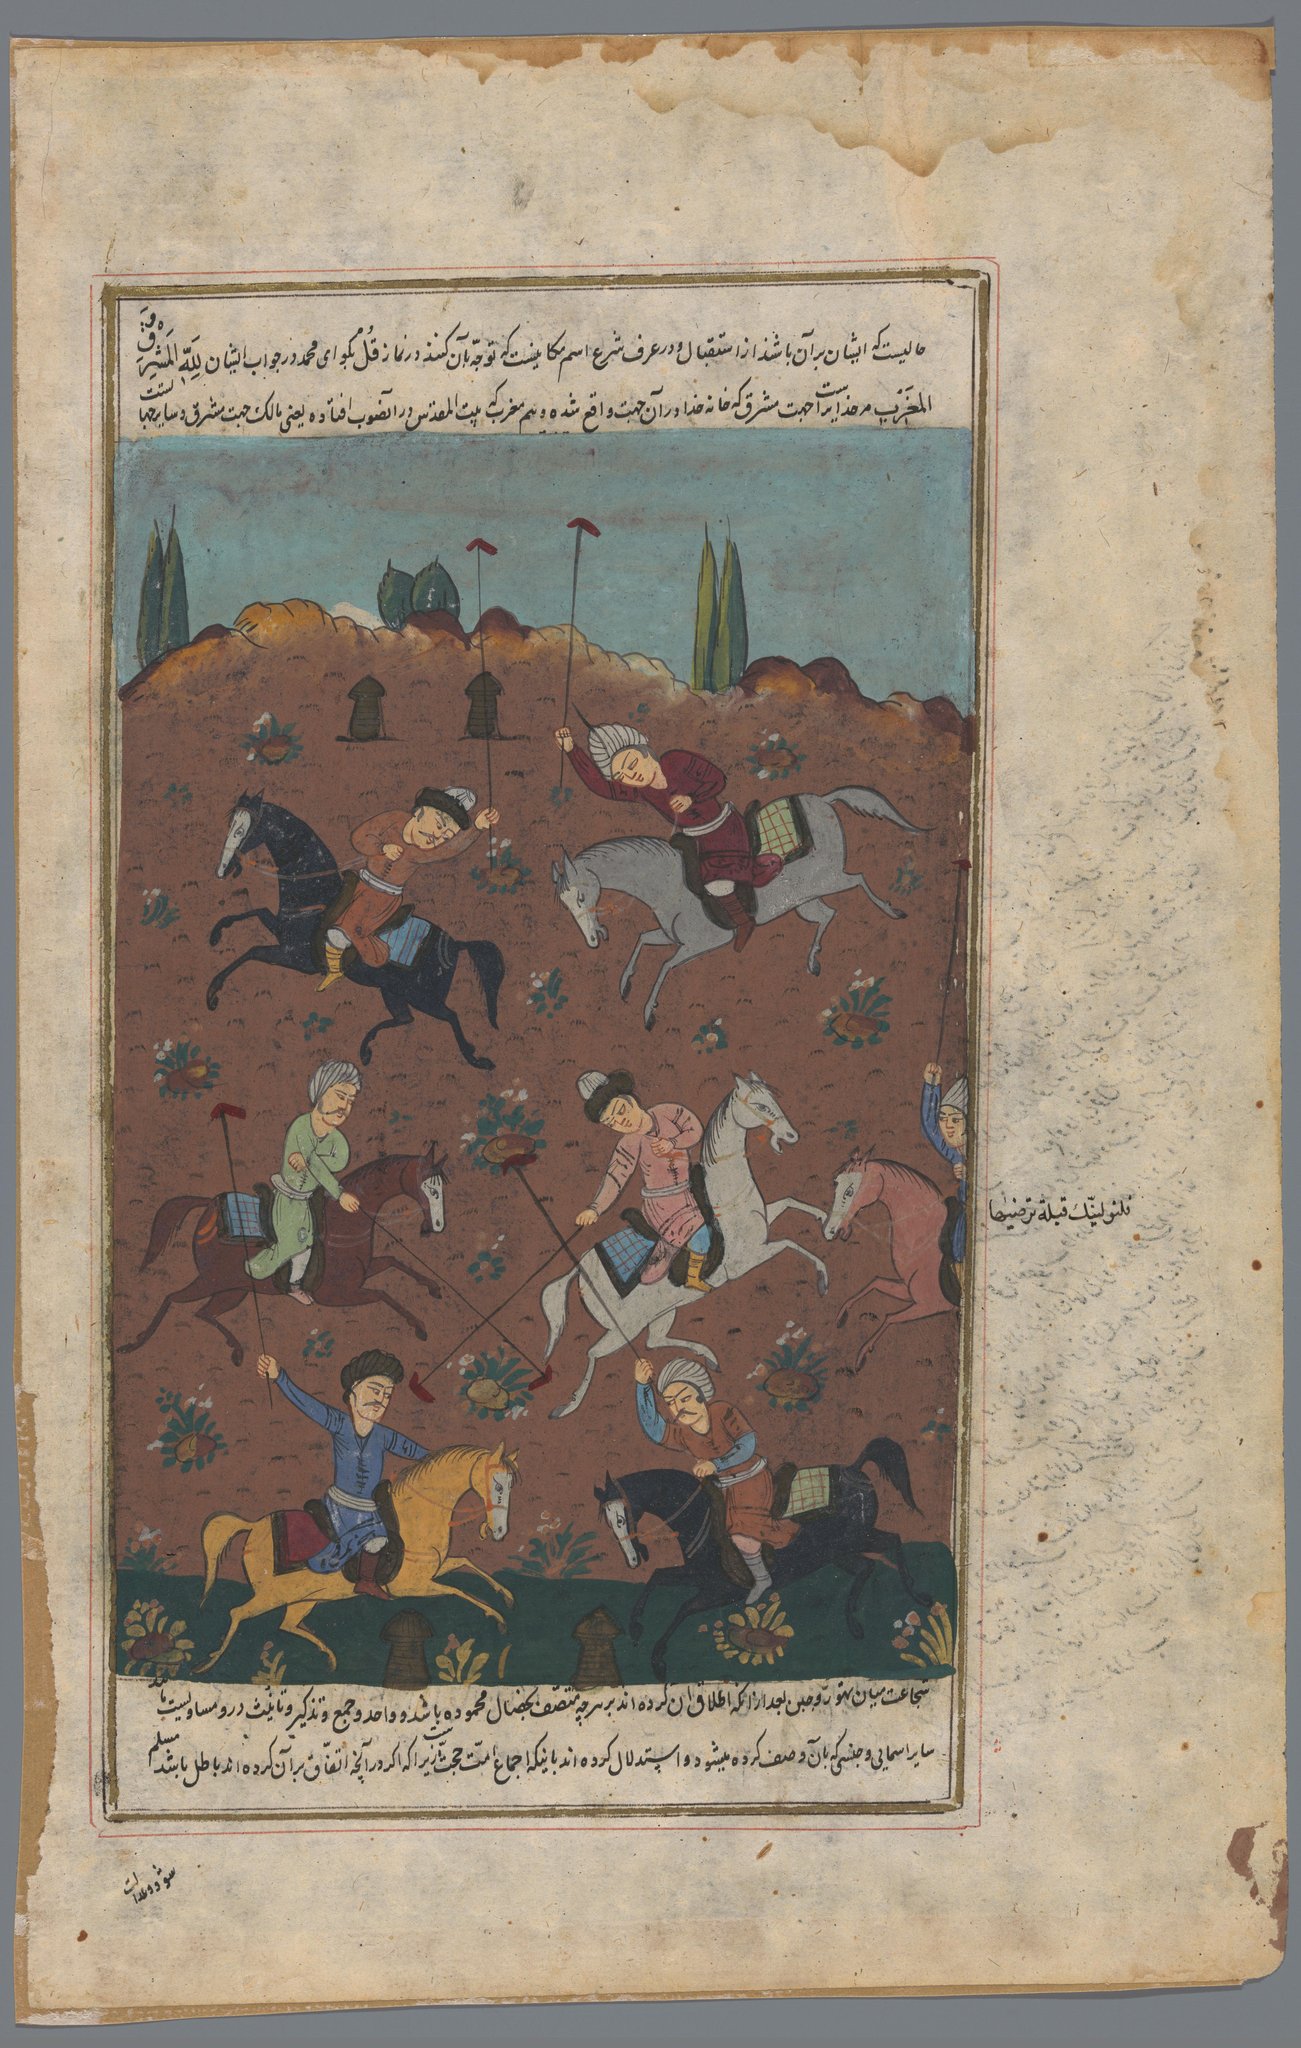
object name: indian miniature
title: Polospelers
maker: Anonymous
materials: paper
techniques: brush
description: Zes polospelers afgebeeld tegen een bruine achtergrond. De scène is getekend op een ouder blad met Perzisch schrift; schrijft ook op de achterkant.